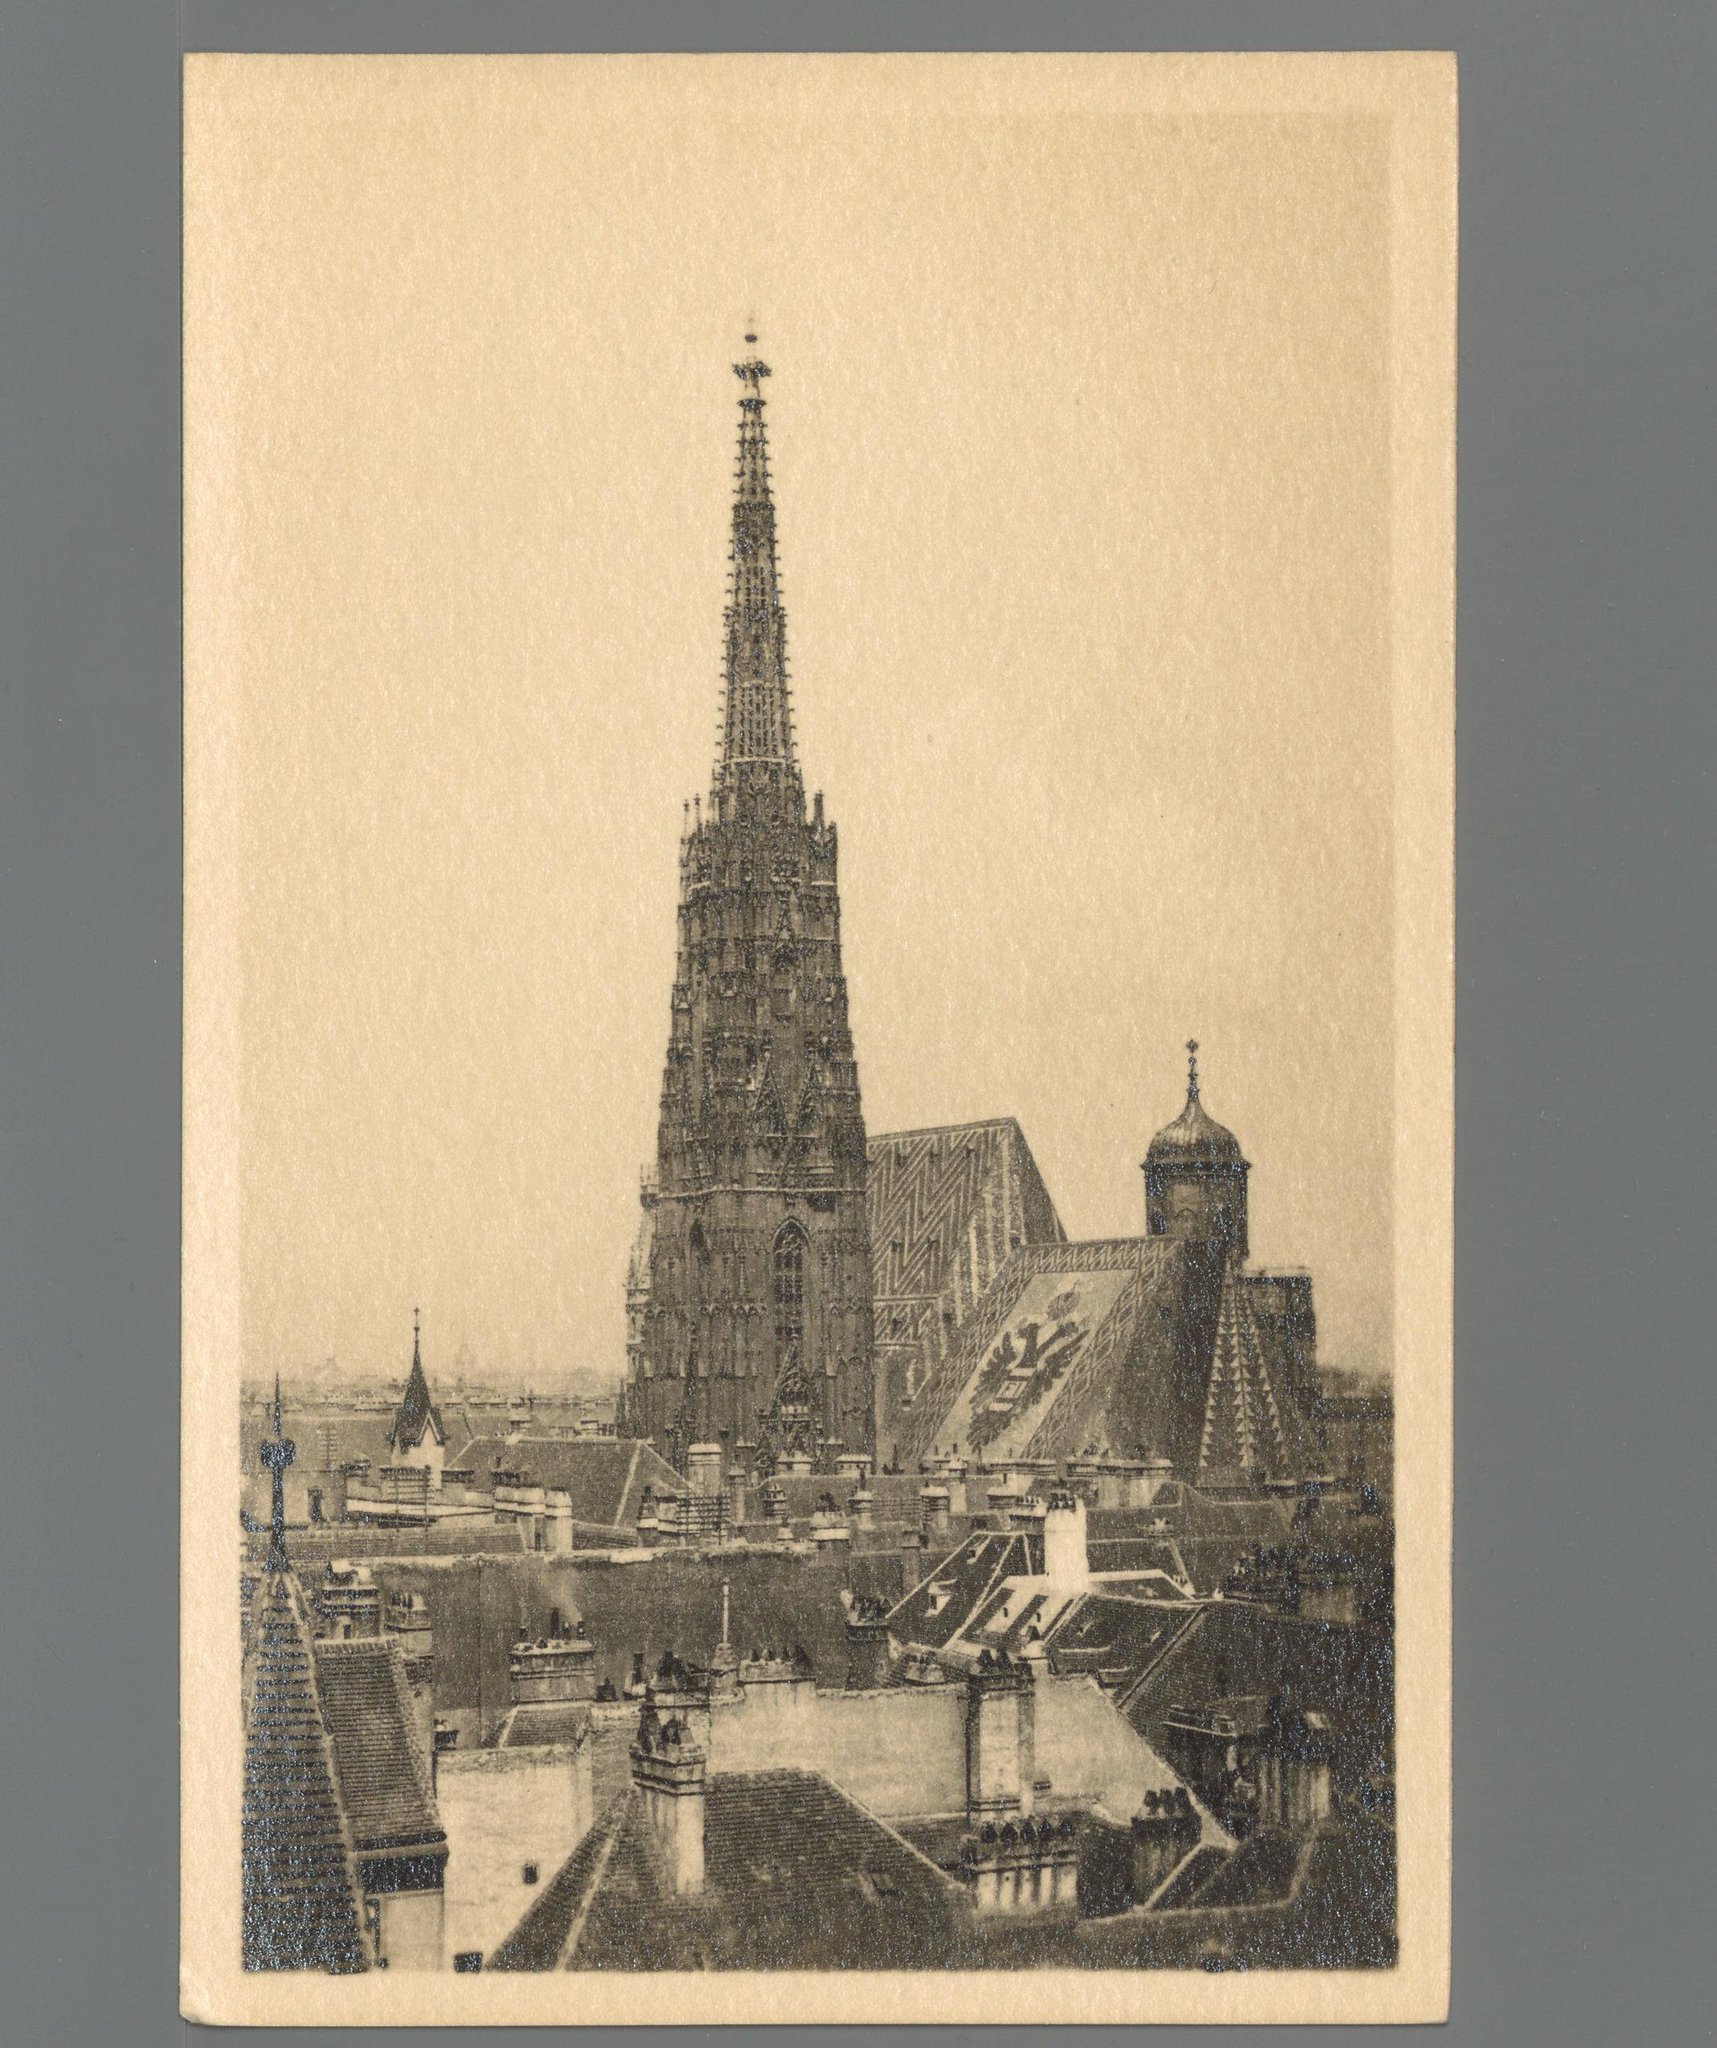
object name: ansichtkaart, prentbriefkaart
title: Wien, Stefanskirche v. Franziskanerturm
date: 1904-1930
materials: paper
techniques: gelatin silver print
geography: vienna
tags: church (exterior)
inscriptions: inscription: ‘K.L.’